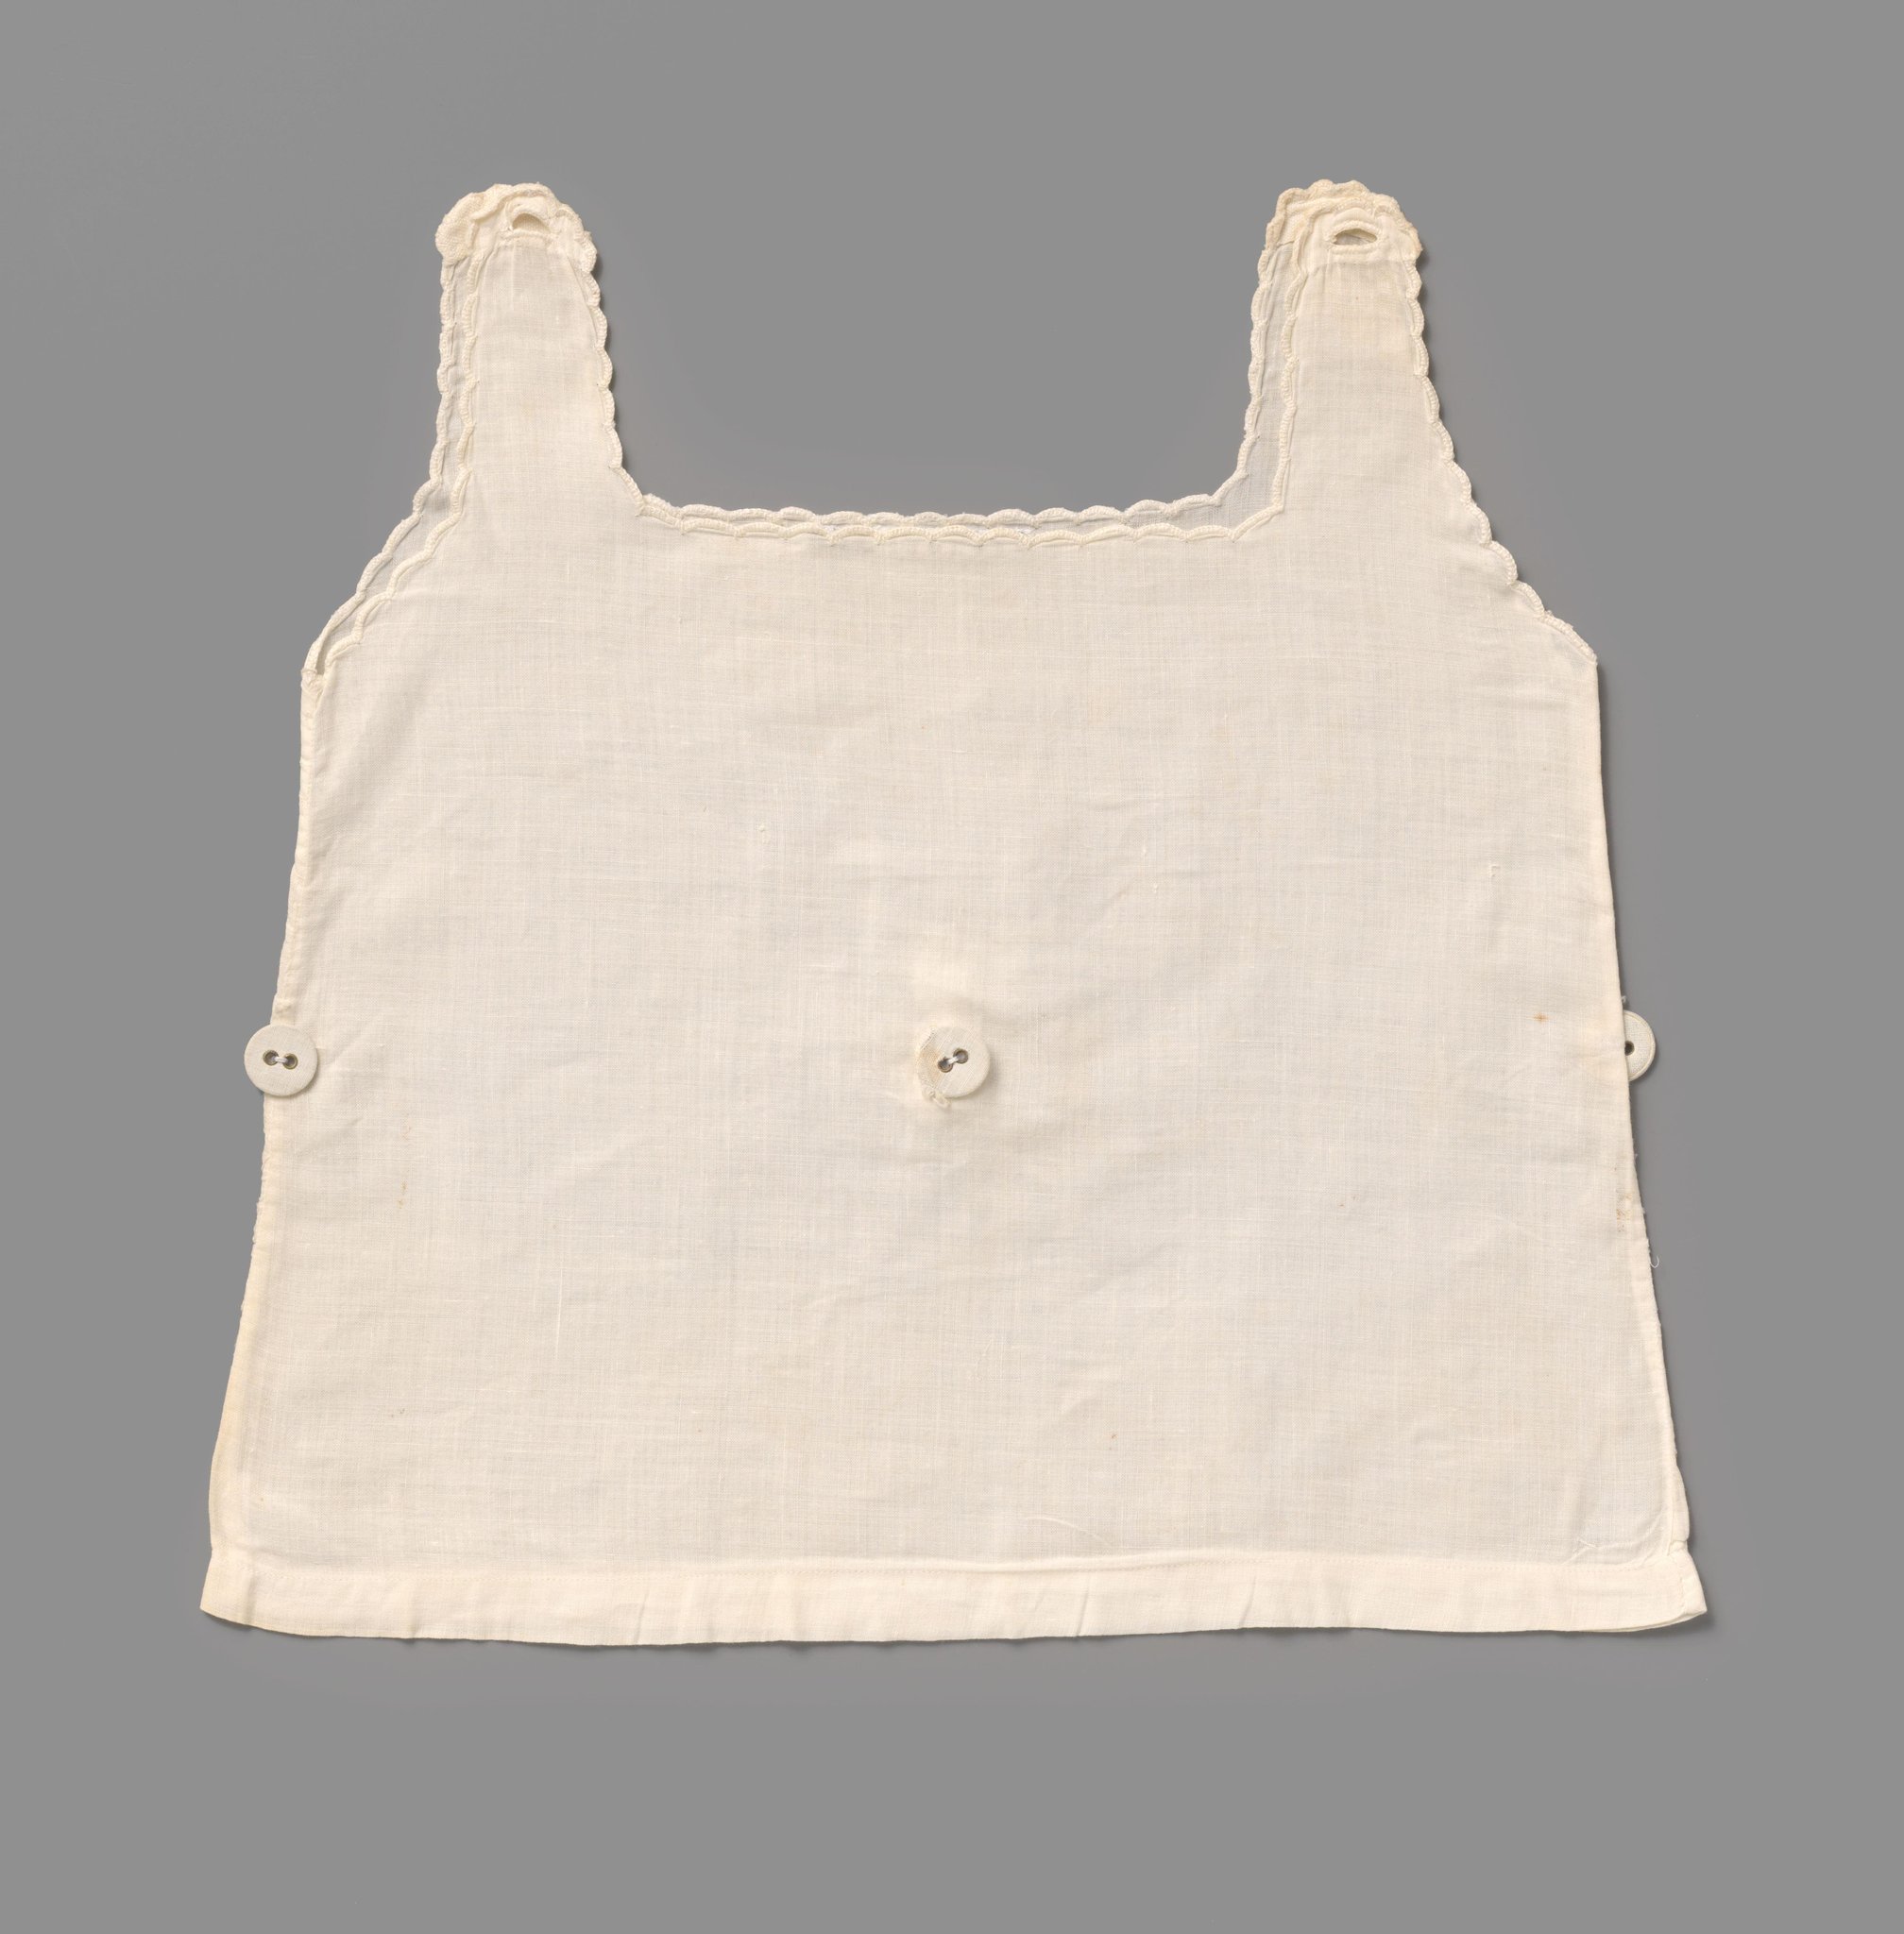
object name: underwear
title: Wit linnen hemd met een gefestonneerde gegolfde hals en armsgaten, afgezet met een strookje machinale kant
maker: Anonymous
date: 1922-1923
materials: linen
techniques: festooning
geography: indonesia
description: Een linnen babyhemdje met een ronde hals, zonder mouwen, afgezet met een smal strookje machinale kant. Gedragen door mevr. C.U.E. Prior-Boissevain als kind.